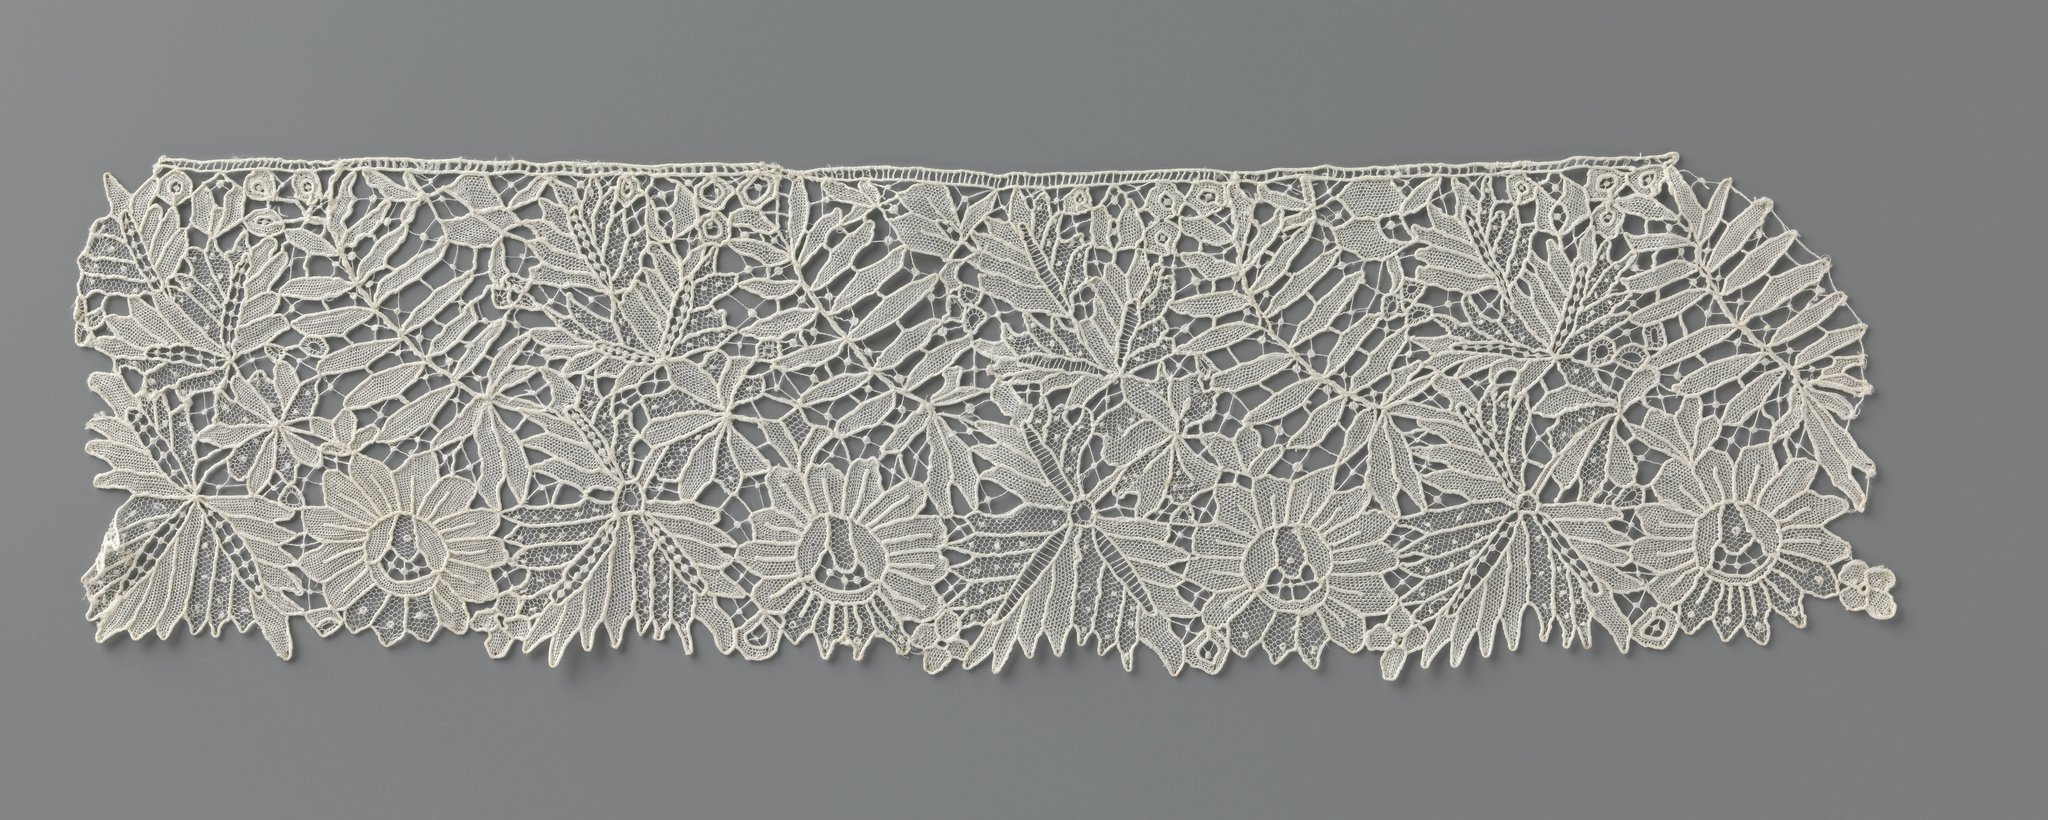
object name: strip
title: Strook naaldkant met ingesneden blad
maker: Anonymous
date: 1900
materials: linen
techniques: needle lace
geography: germany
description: Lopend patroon van ingesneden bladeren boven een roos en een drieblad, die samen de scherp getande buitenlijn vormen. Kruisvormige spijlen met knoopje (grond van lange X-vormige spijlen met een spin). Het remplis bestaat uit knoopsgatensteken en een fond gazé. Duitse kant: 'Carlsbader Points'.